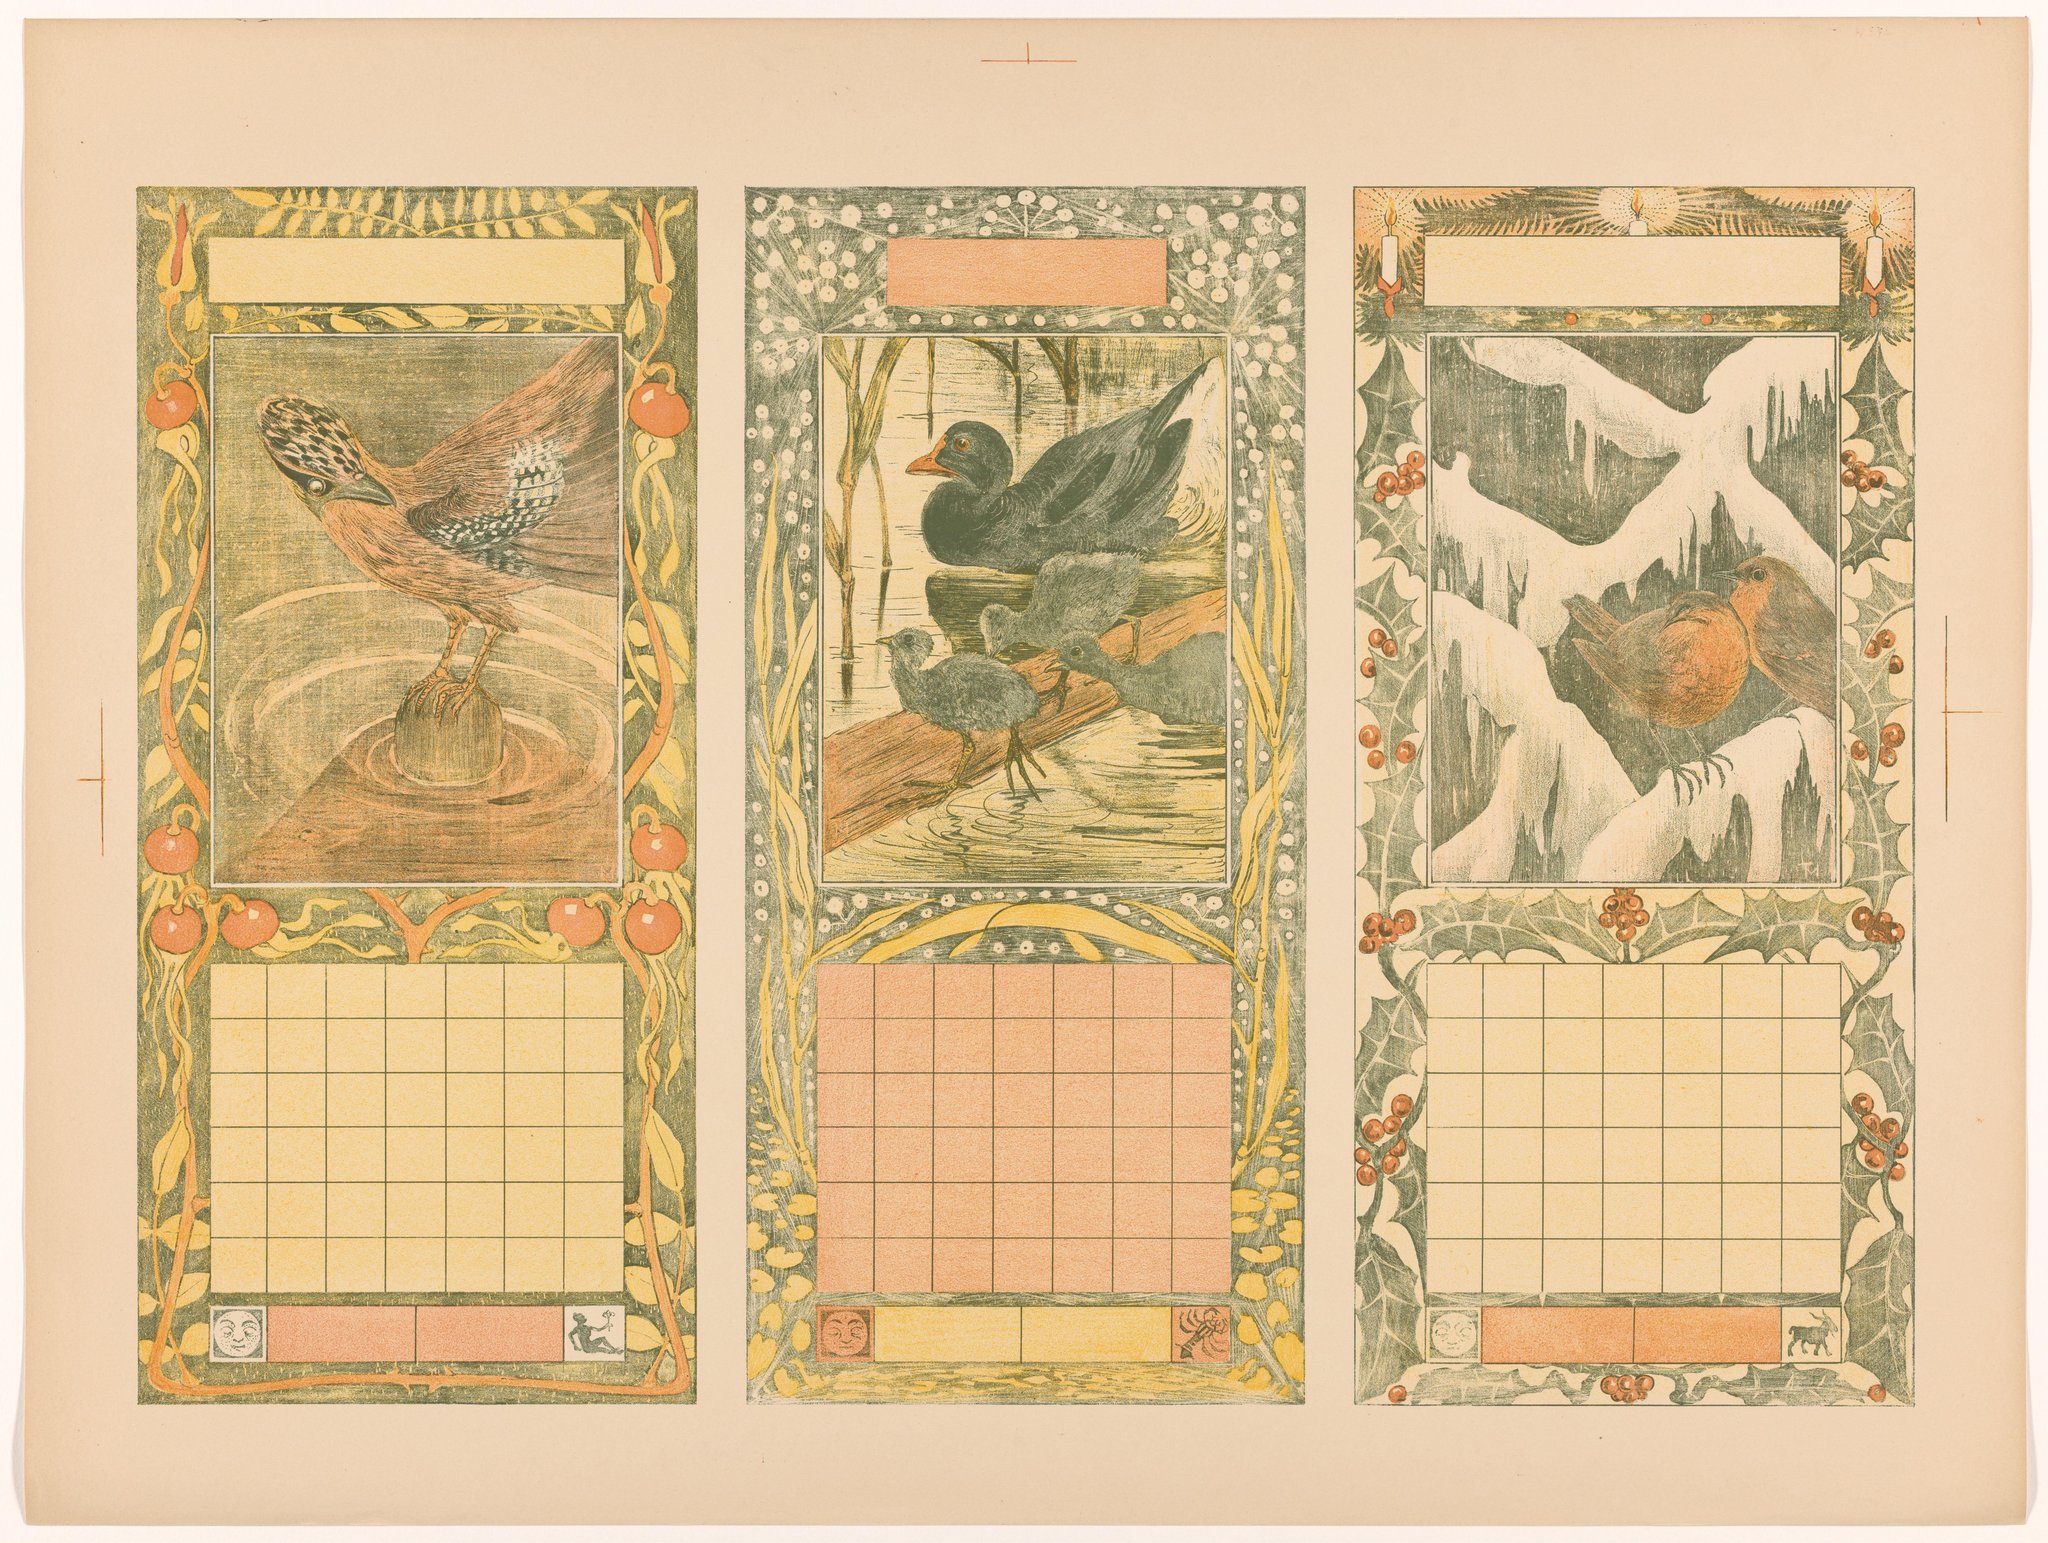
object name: print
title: Kalenders voor augustus, juni en december 1904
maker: theo van hoytema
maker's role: draughtsman, painter, print maker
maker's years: 1863-1917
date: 1904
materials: paper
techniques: lithograph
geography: amsterdam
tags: calendar, almanac, water-birds: swamp-hen, song-birds: robin, song-birds: jay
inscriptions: collector's mark: Lugt 2233